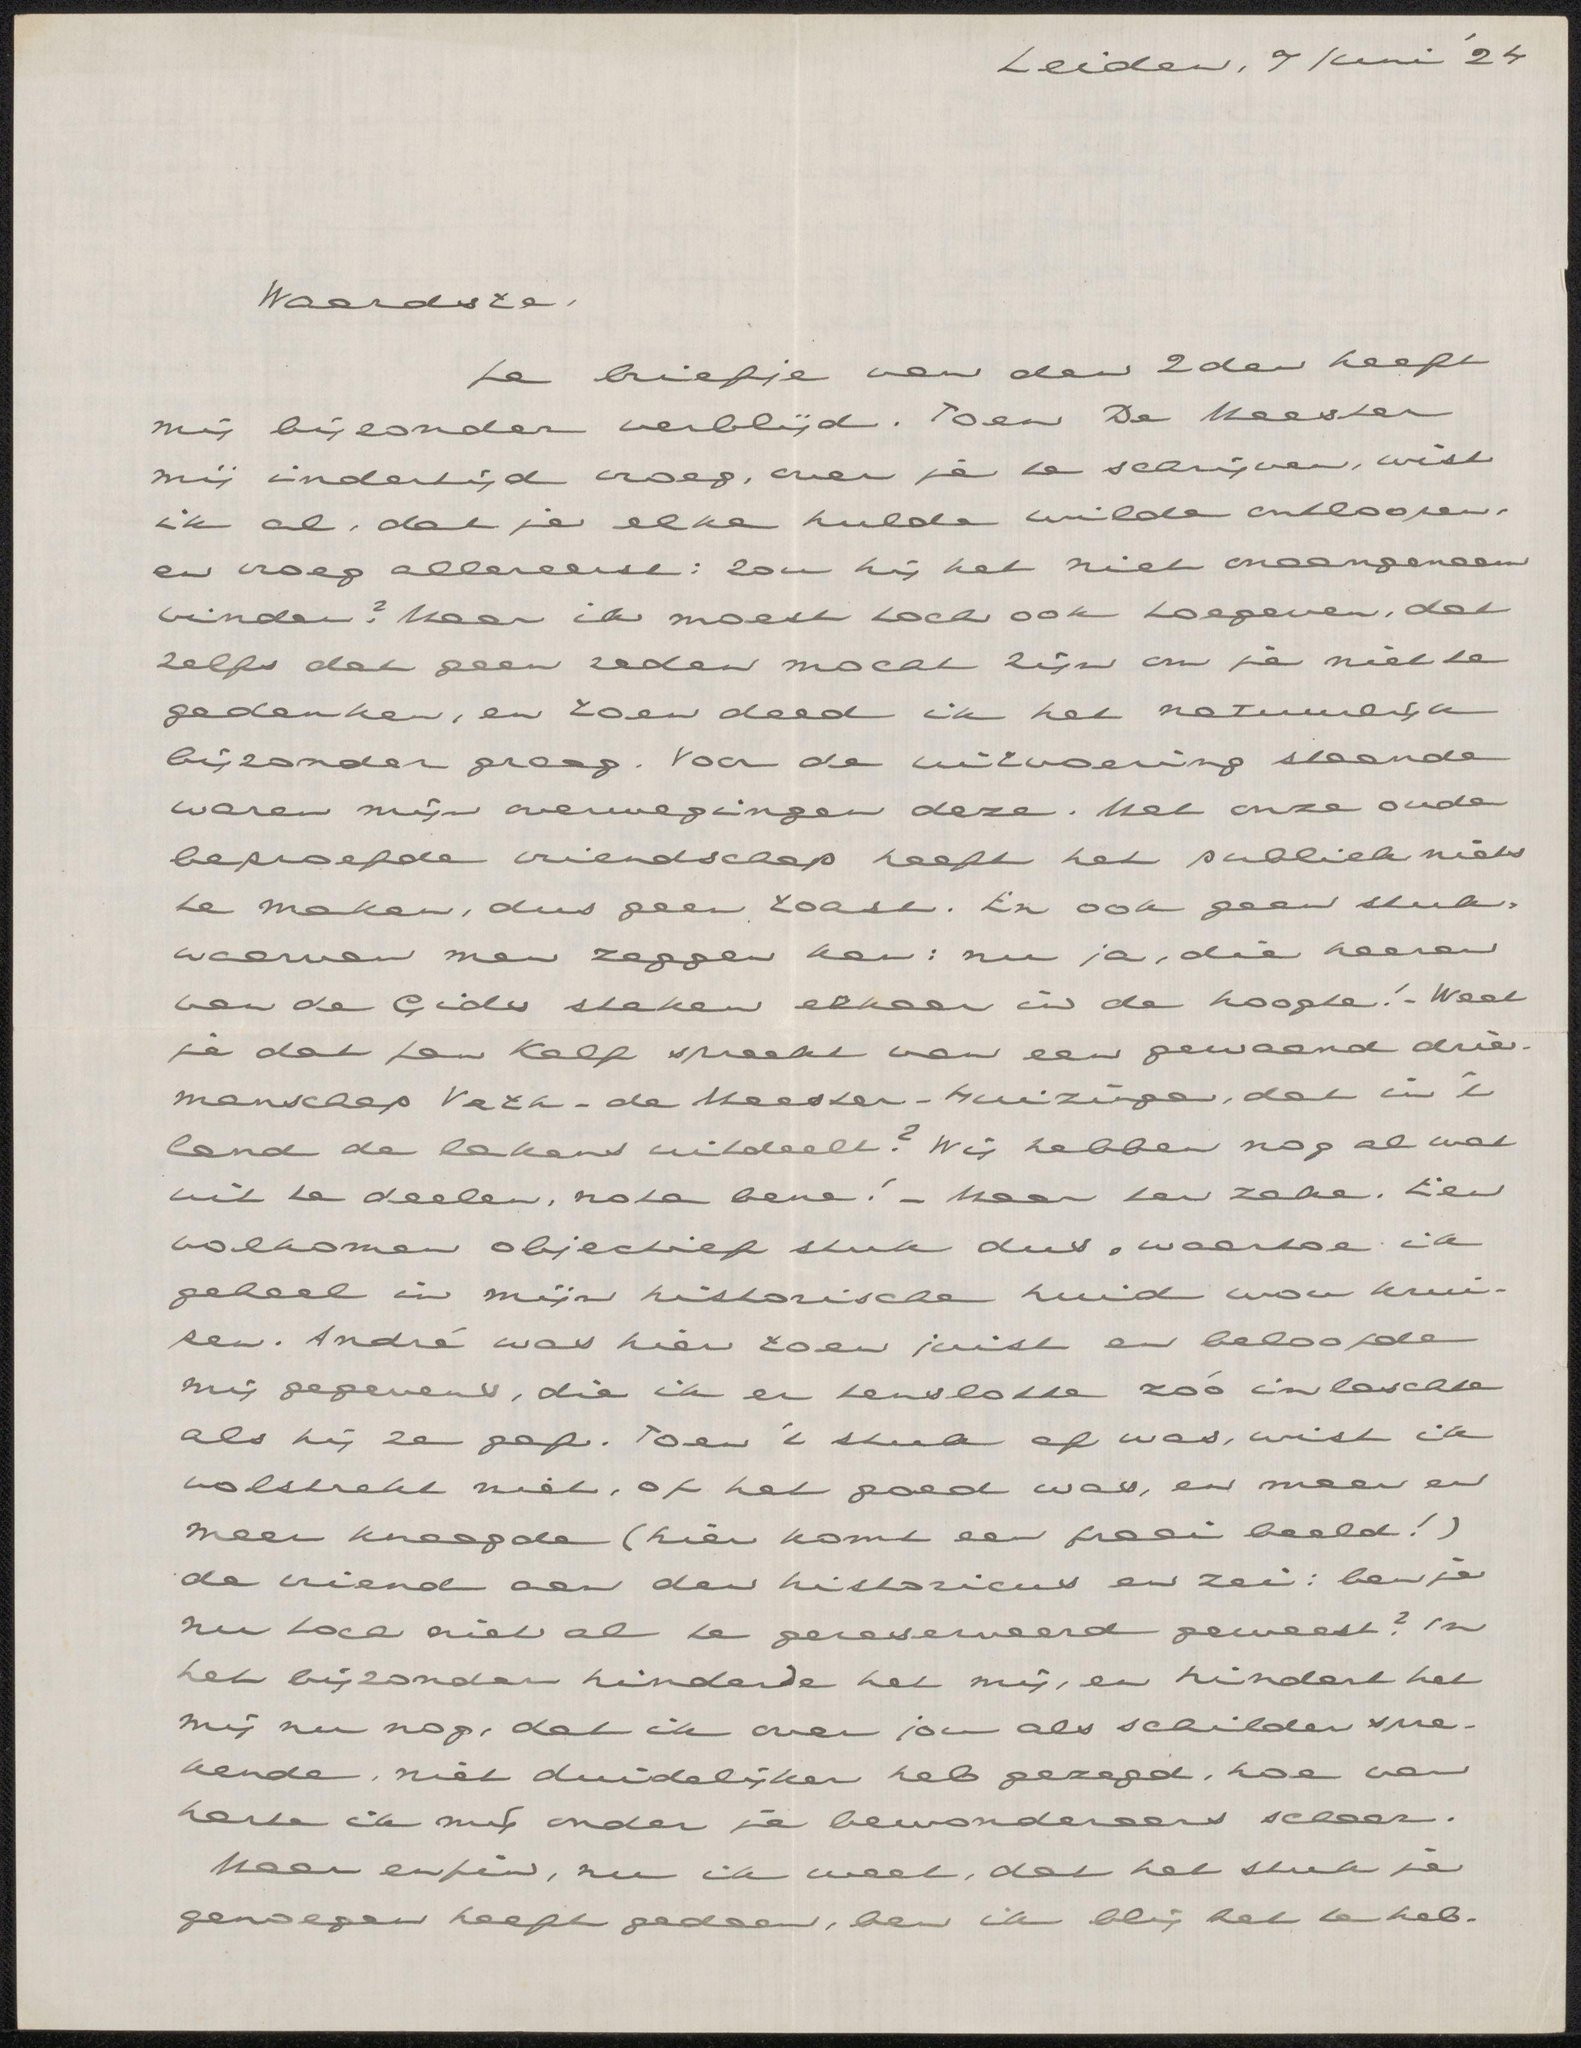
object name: letter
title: Brief aan Jan Veth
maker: johan huizinga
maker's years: 1872-1945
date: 1924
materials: ink, paper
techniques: pen, writing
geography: leiden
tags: dordrecht, amsterdam, painter, print maker, draughtsman, designer, jan veth, jan kalf, andré jolles, utrecht, johan de meester, diseases, switzerland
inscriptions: watermark, collector's mark: ‘RPK’